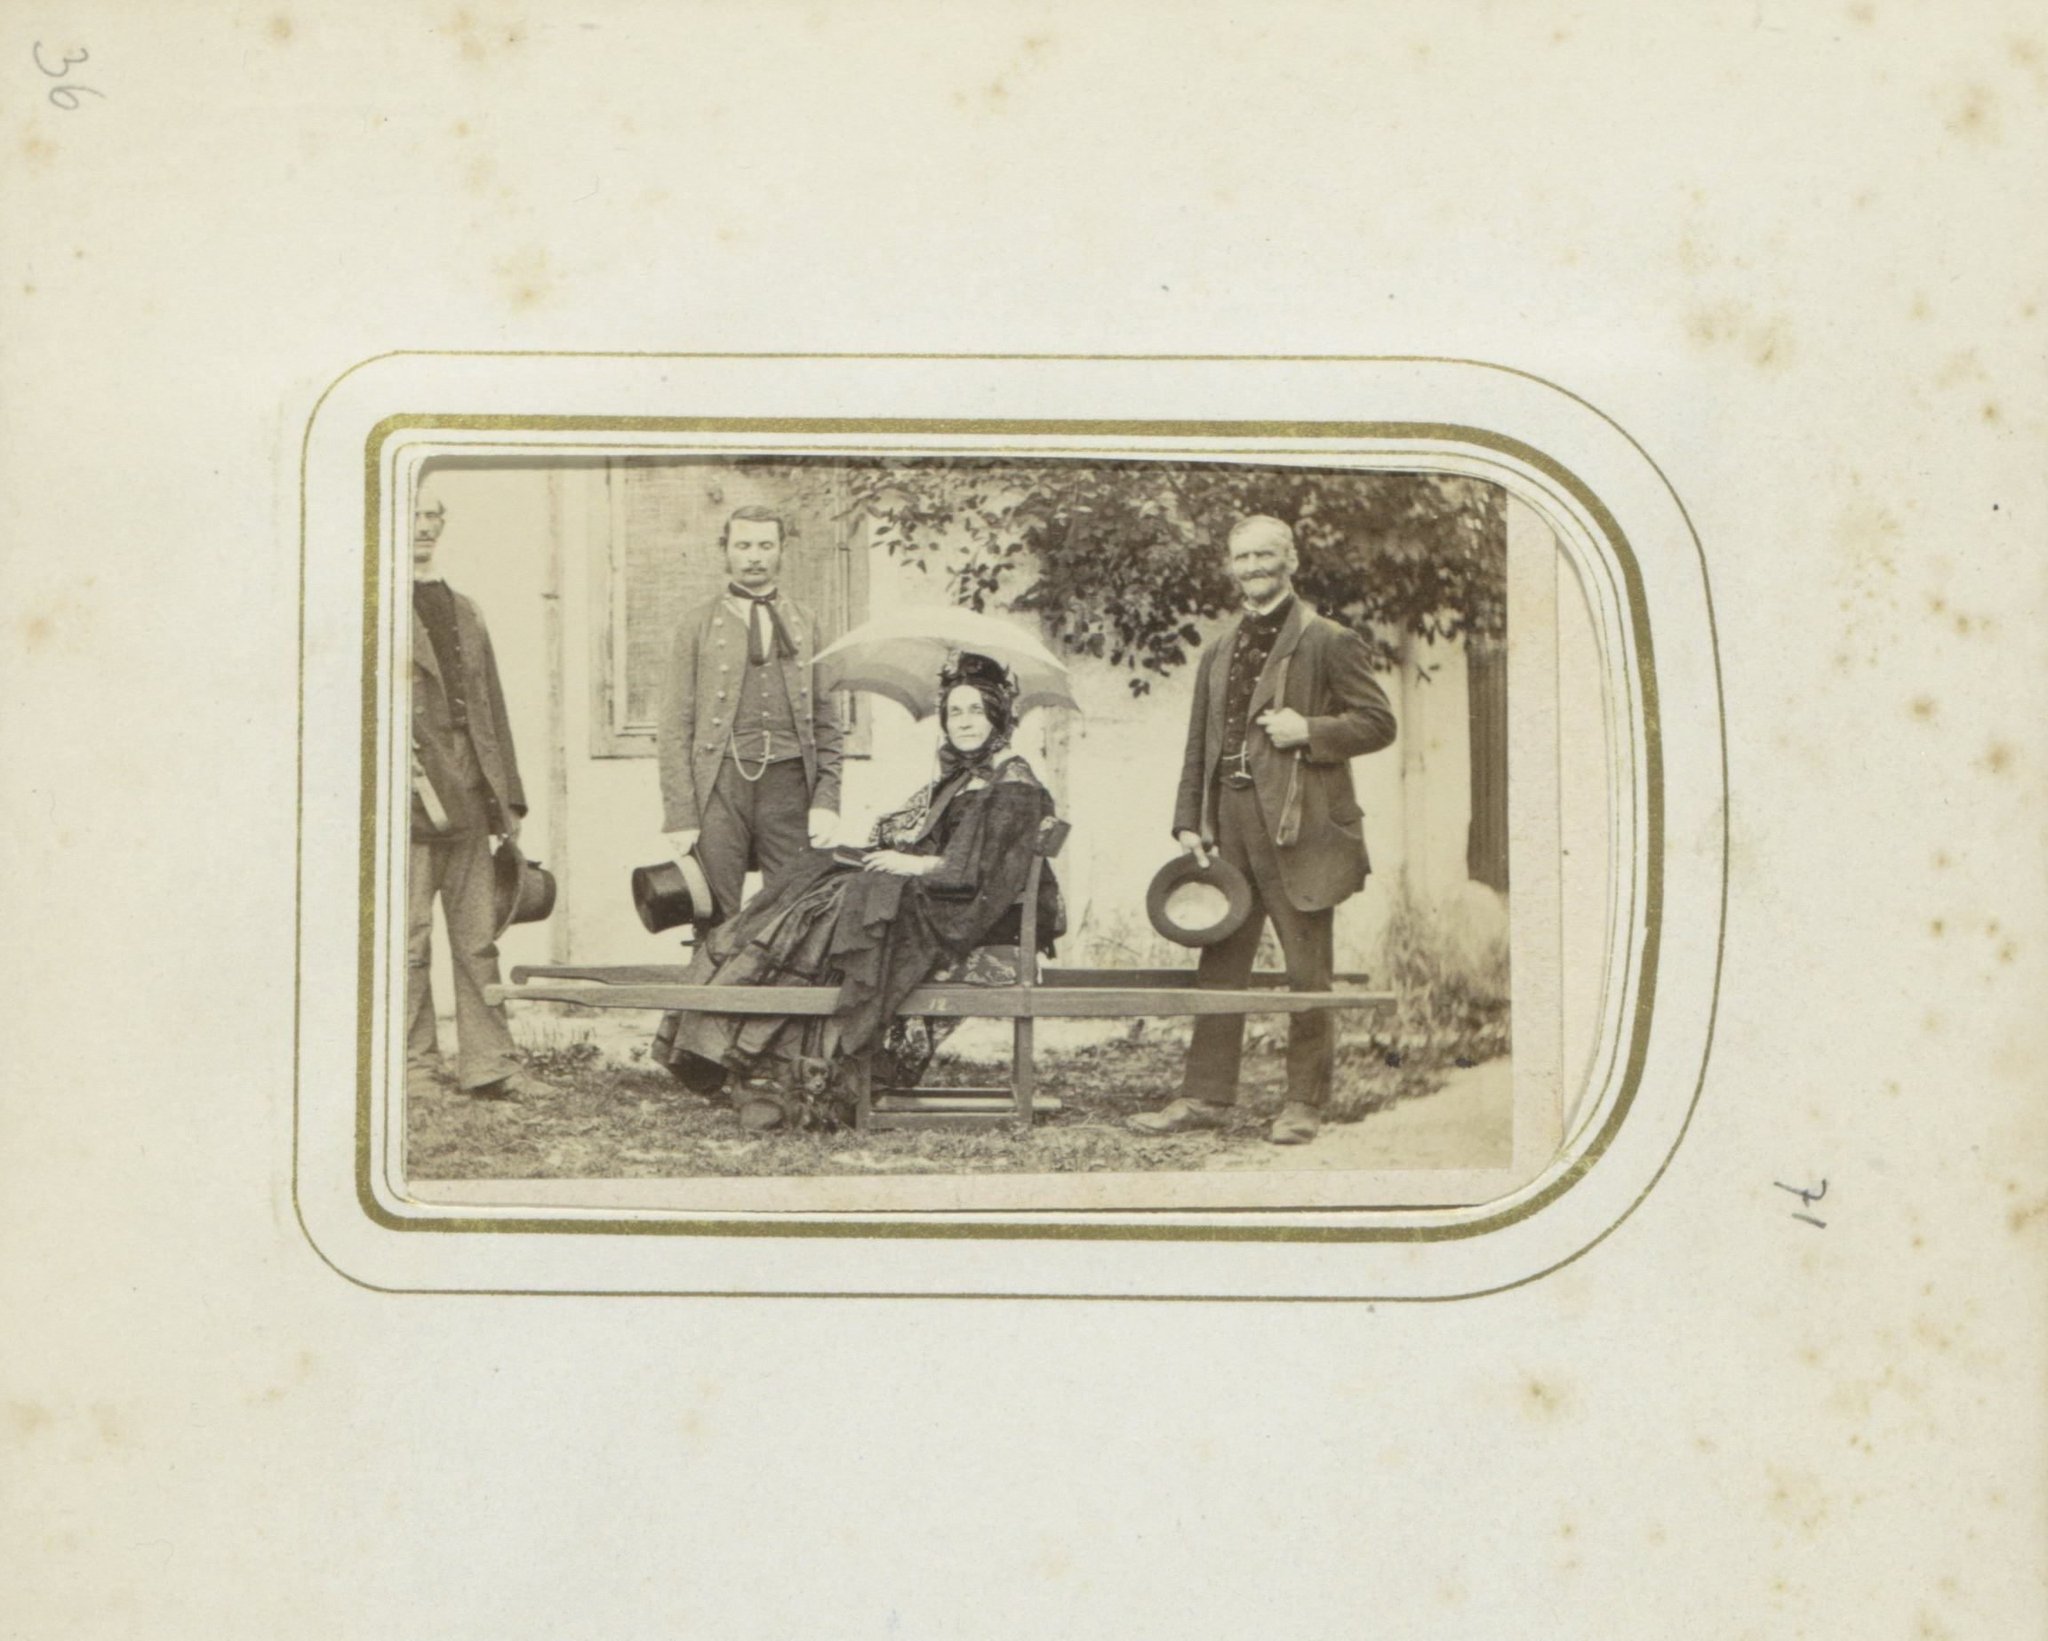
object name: photograph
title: Drie mannen en een vrouw in een draagstoel in Ischl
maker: victor angerer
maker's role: publisher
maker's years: 1839-1924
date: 1865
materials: paper, photographic support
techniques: albumen print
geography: ischl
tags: clothing for the lower part of the body, (carrying a person in a) sedan-chair, neck-gear ~ clothing, clothing for the upper part of the body, skirt, head-gear: hat, travelling; tourism, watch, parasol, sunshade, coat, cape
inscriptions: address: ‘Aufgenommen in Ischl.’, name: ‘Victor Angerer’, address: ‘Victor Anegerer aus Wien’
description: Onderdeel van Fotoalbum van een reis door Zwitserland, Oostenrijk en Duitsland door de Nederlandse familie Derkinderen.